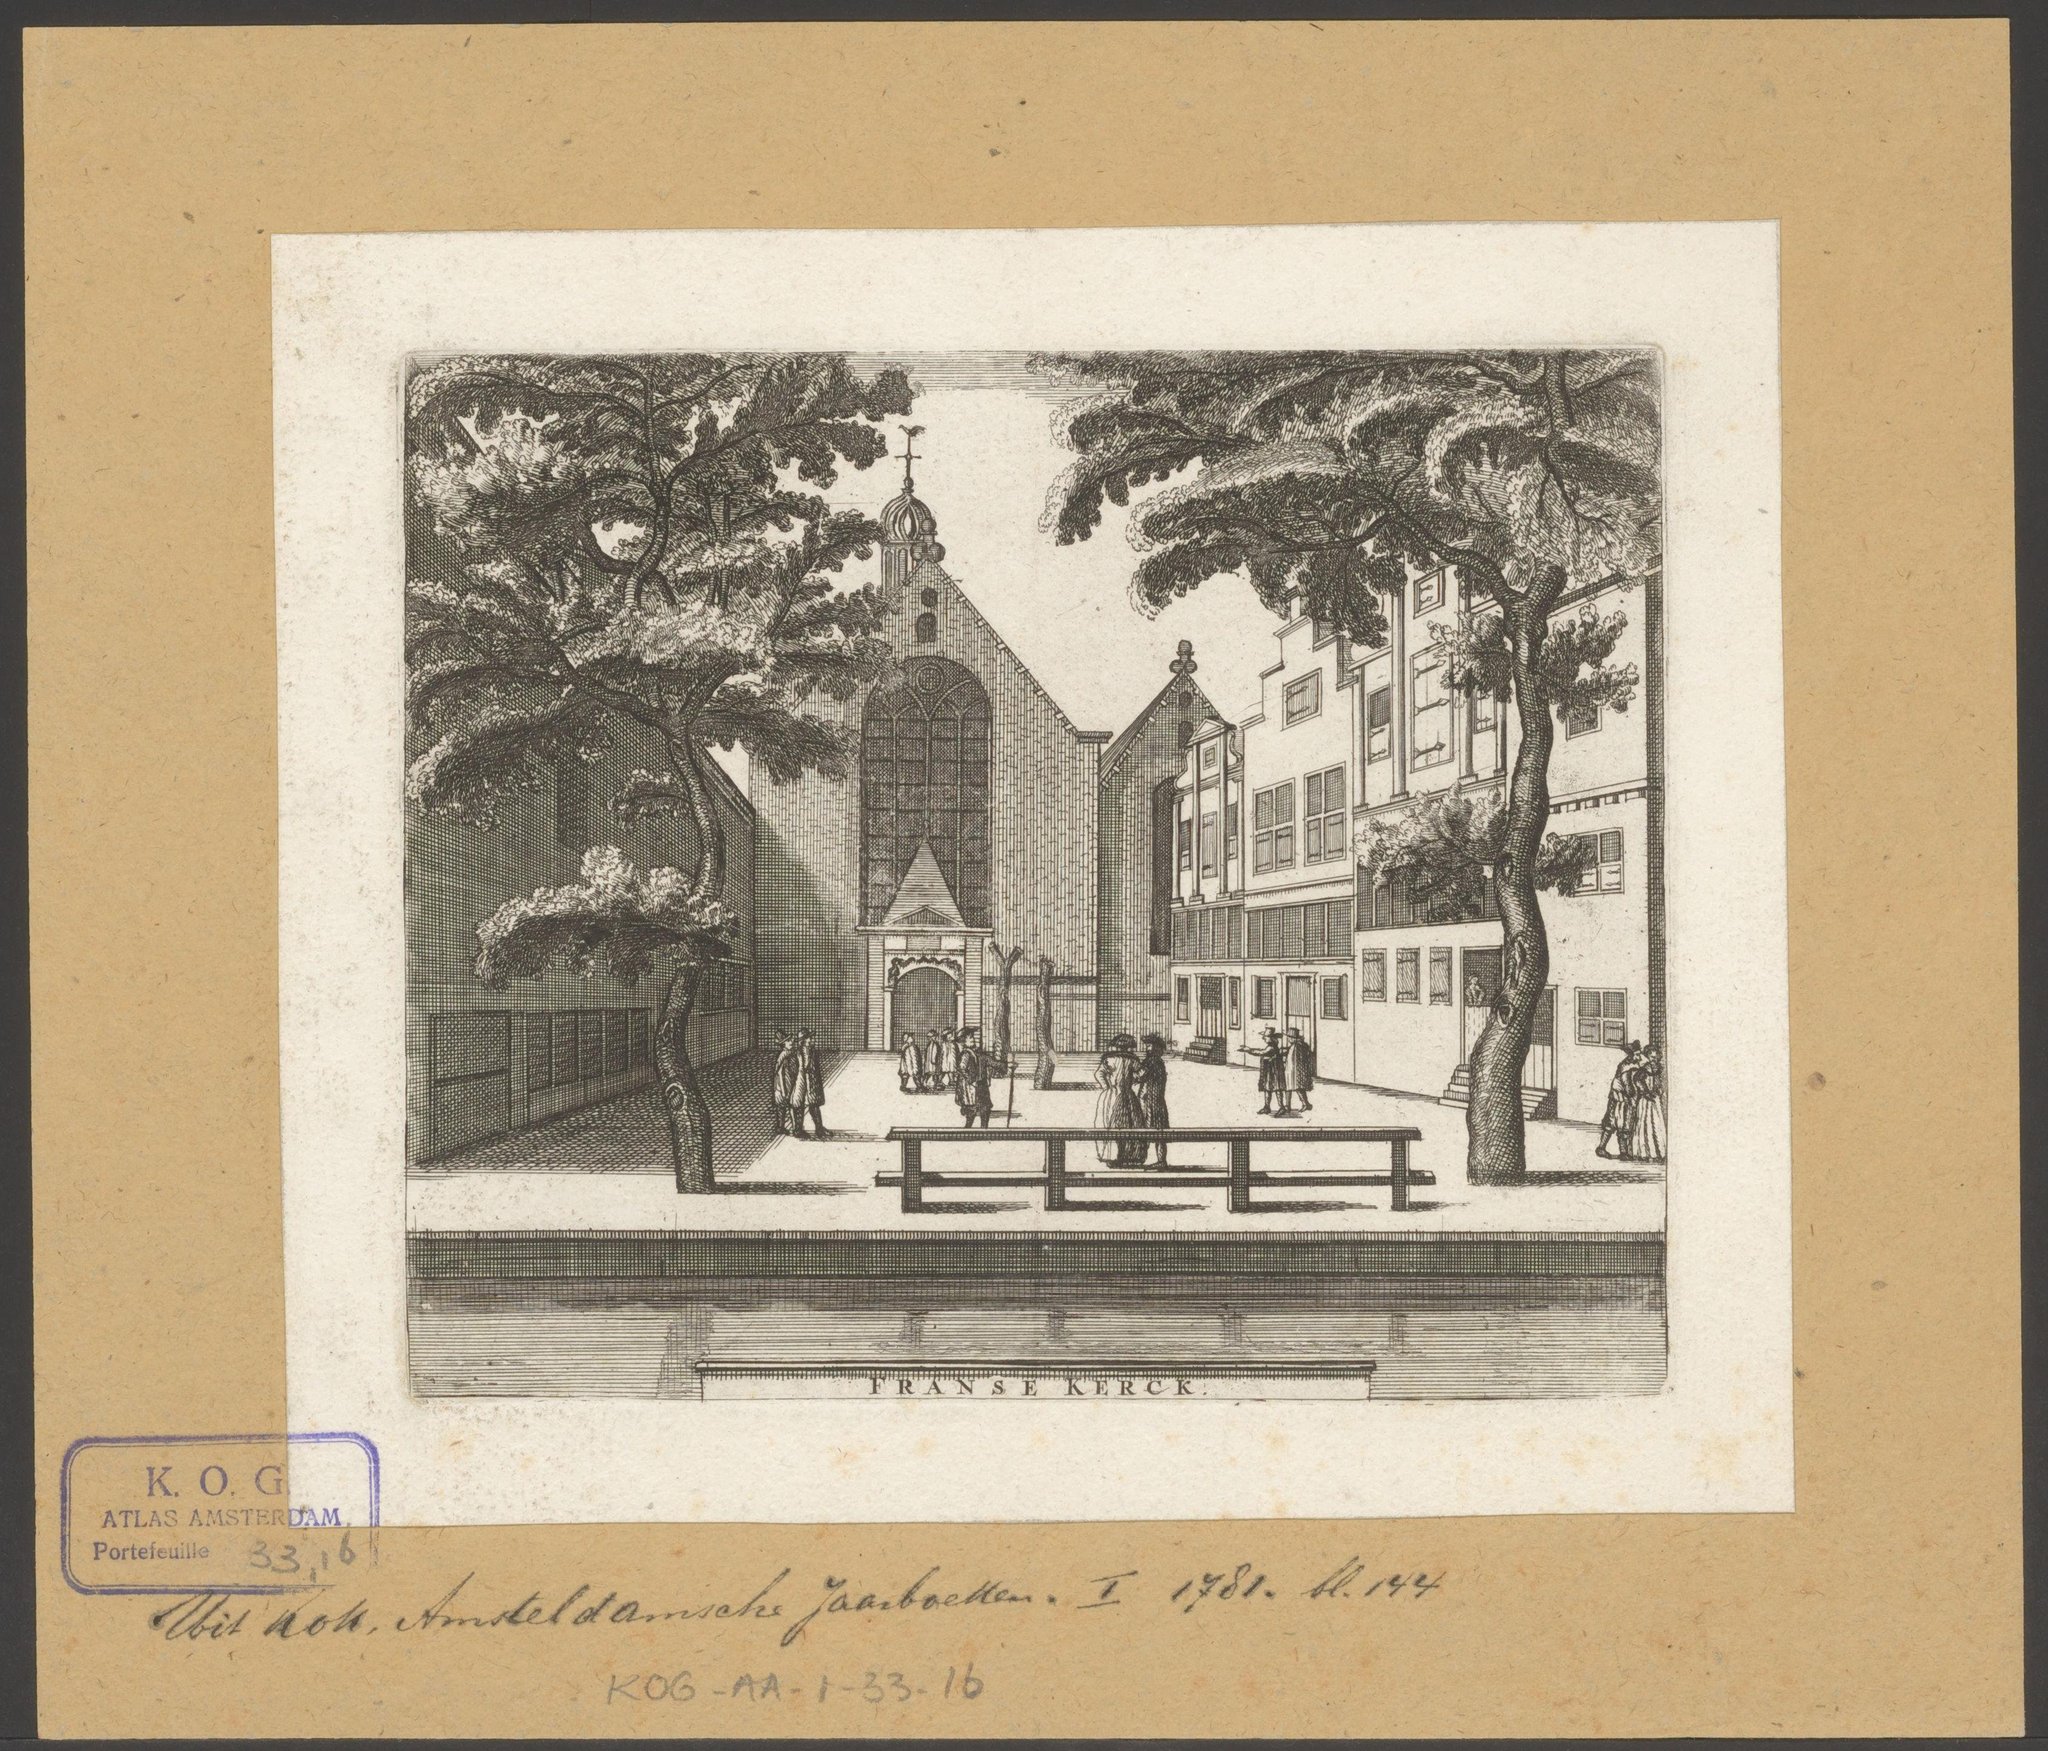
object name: print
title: Franse Kerck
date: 1781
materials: paper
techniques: engraving, etching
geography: amsterdam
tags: church (exterior), square, place, circus, etc. (+ city(-scape) with figures, staffage)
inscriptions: collector's mark: Lugt 1641b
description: Prent mogelijk uit: Kok, Jacobus. Amsteldamsche jaarboeken, behelzende de merkwaardigste geschiedenissen (...). Amsterdam: Jan Barend Elwe, 1781, dl. 1.